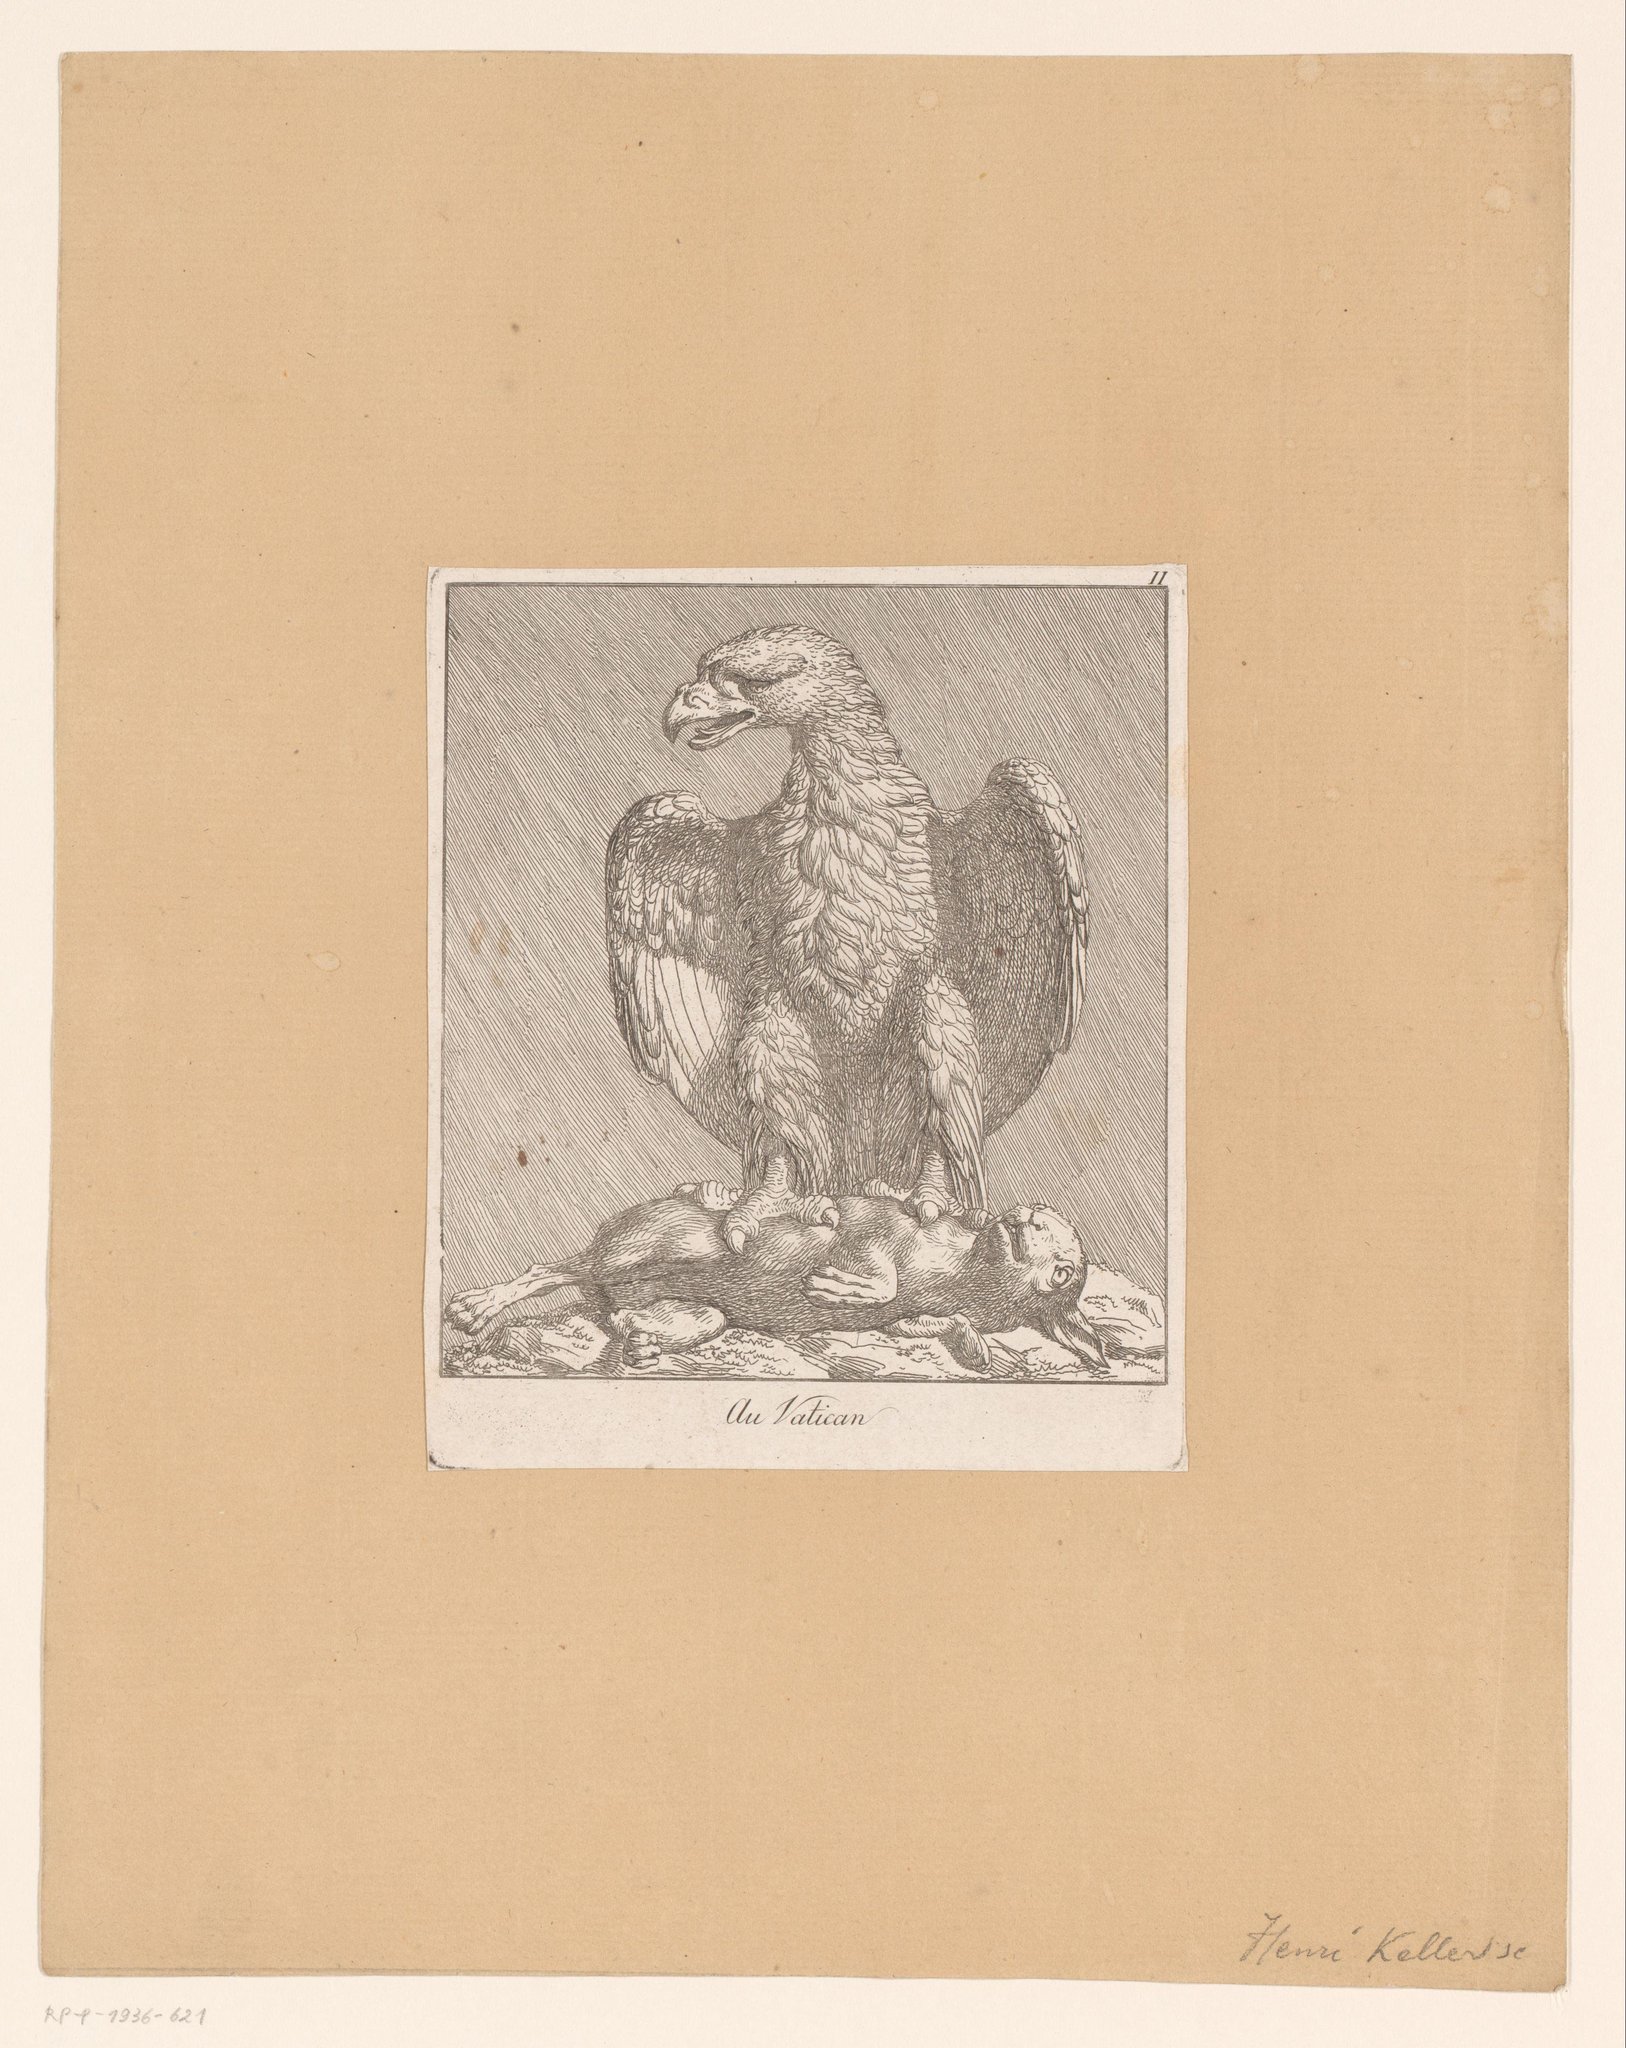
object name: print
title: Adelaar met konijn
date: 1796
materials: paper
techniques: etching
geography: france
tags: predatory birds: eagle, rodents: rabbit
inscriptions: collector's mark: Lugt 2228